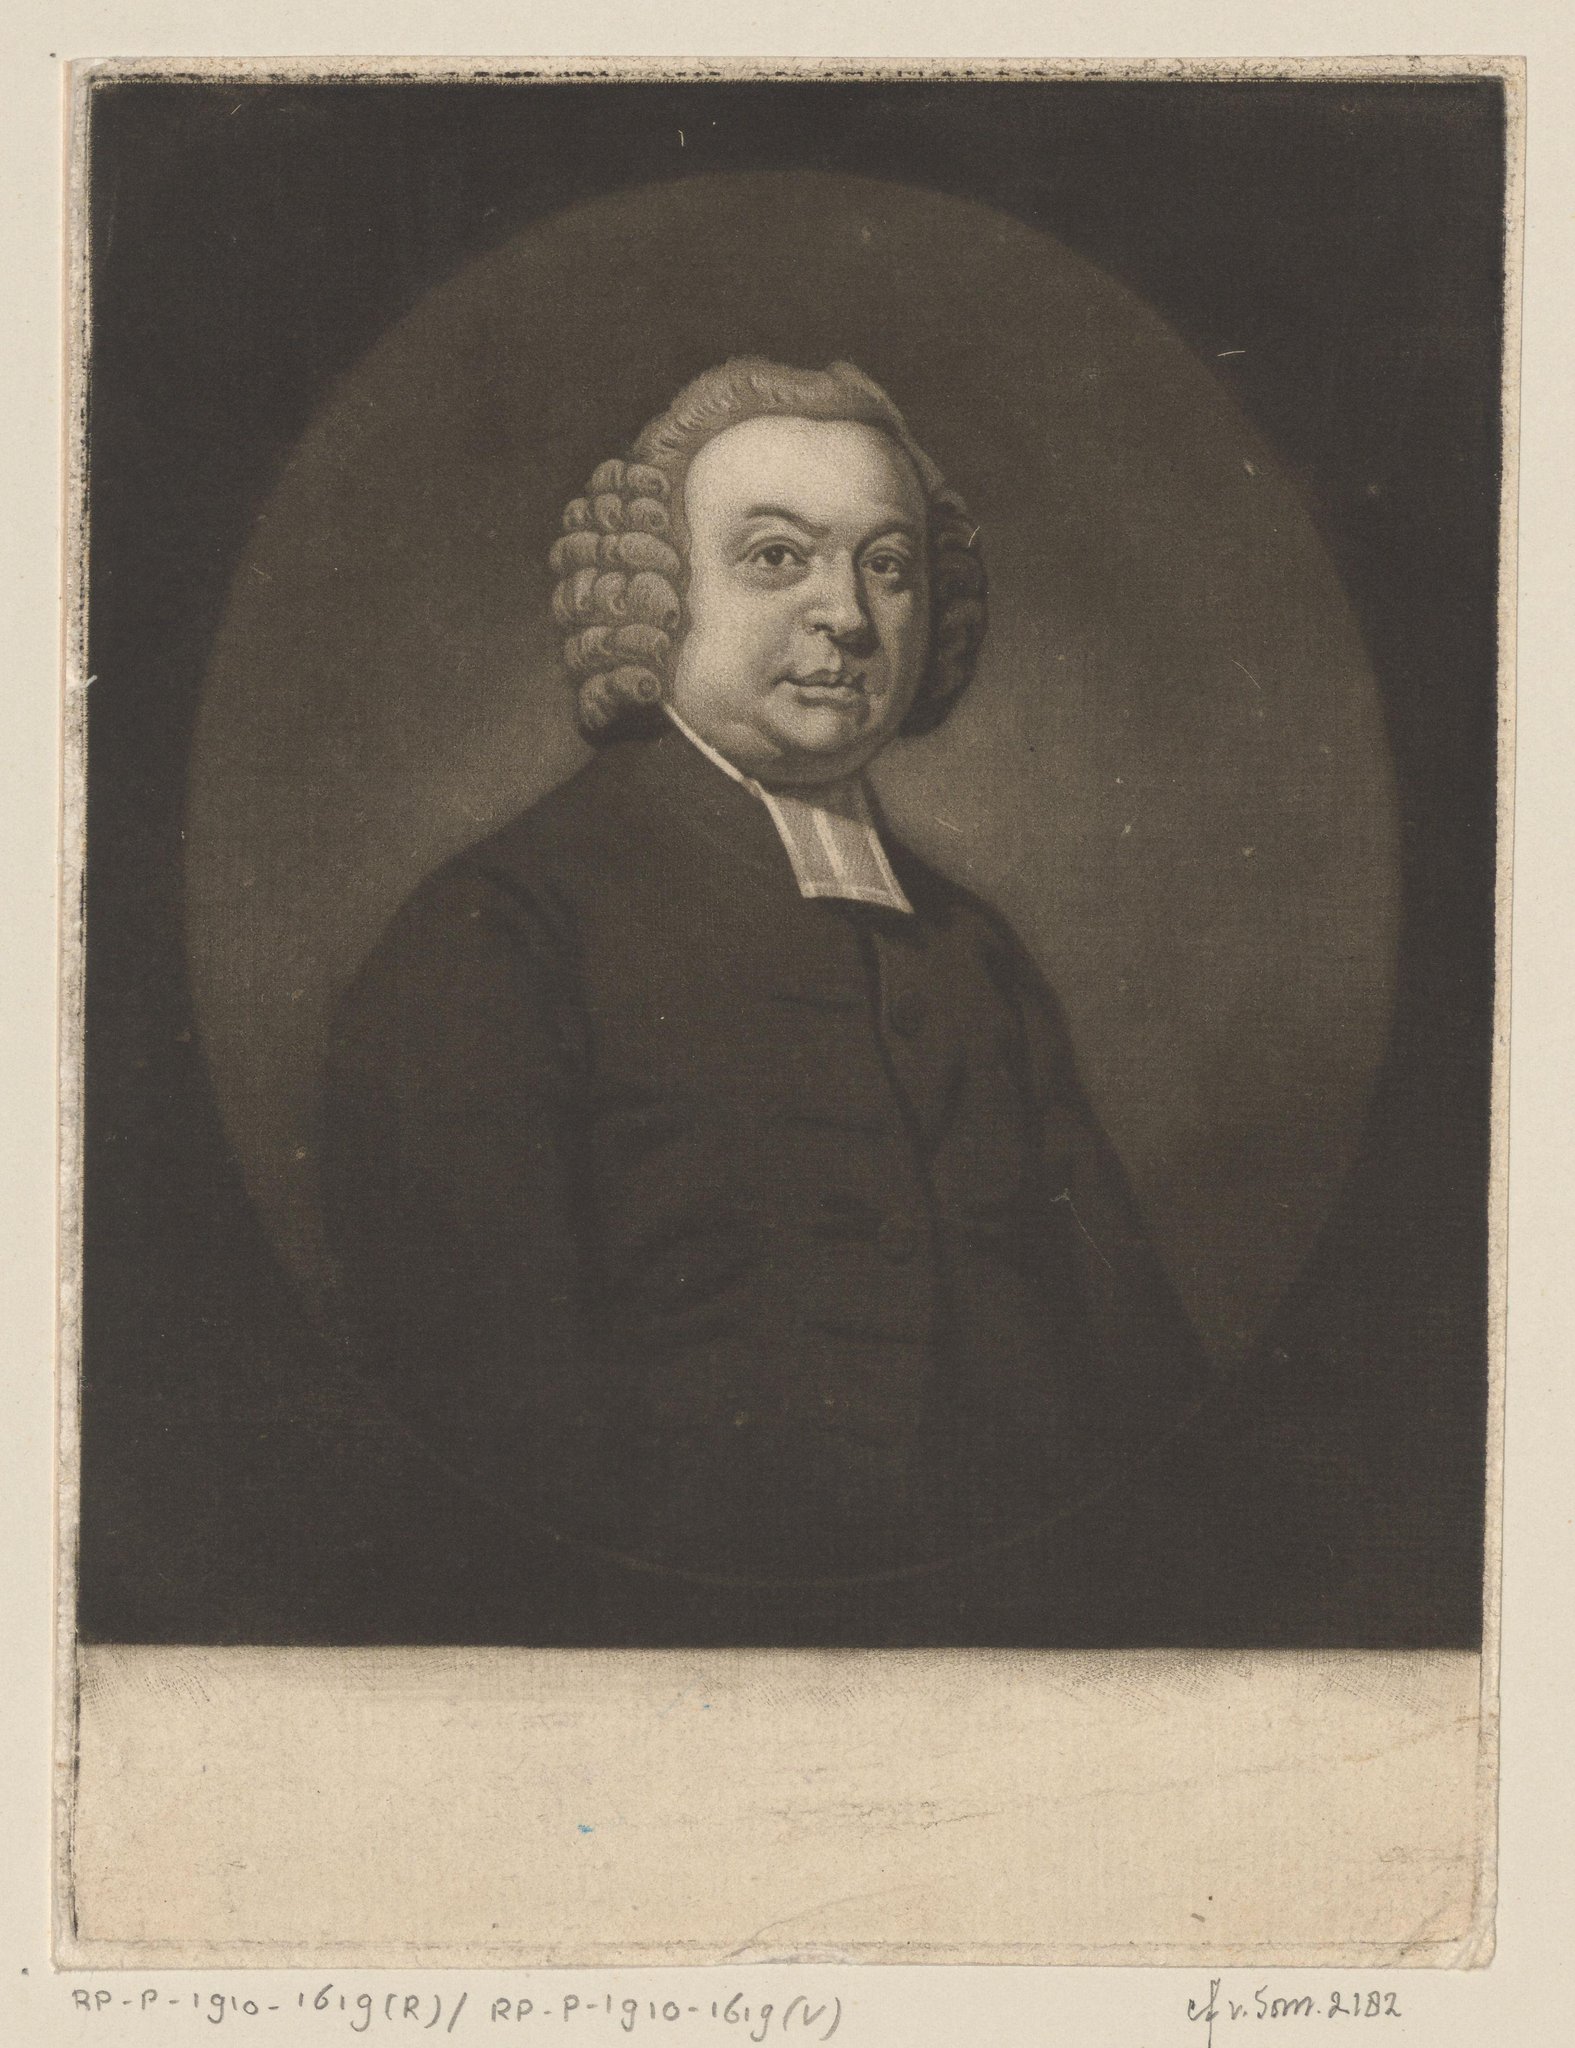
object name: print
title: Portret van Johannes Visch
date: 1794-1830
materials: paper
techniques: mezzotint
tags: utrecht, amsterdam, historical persons